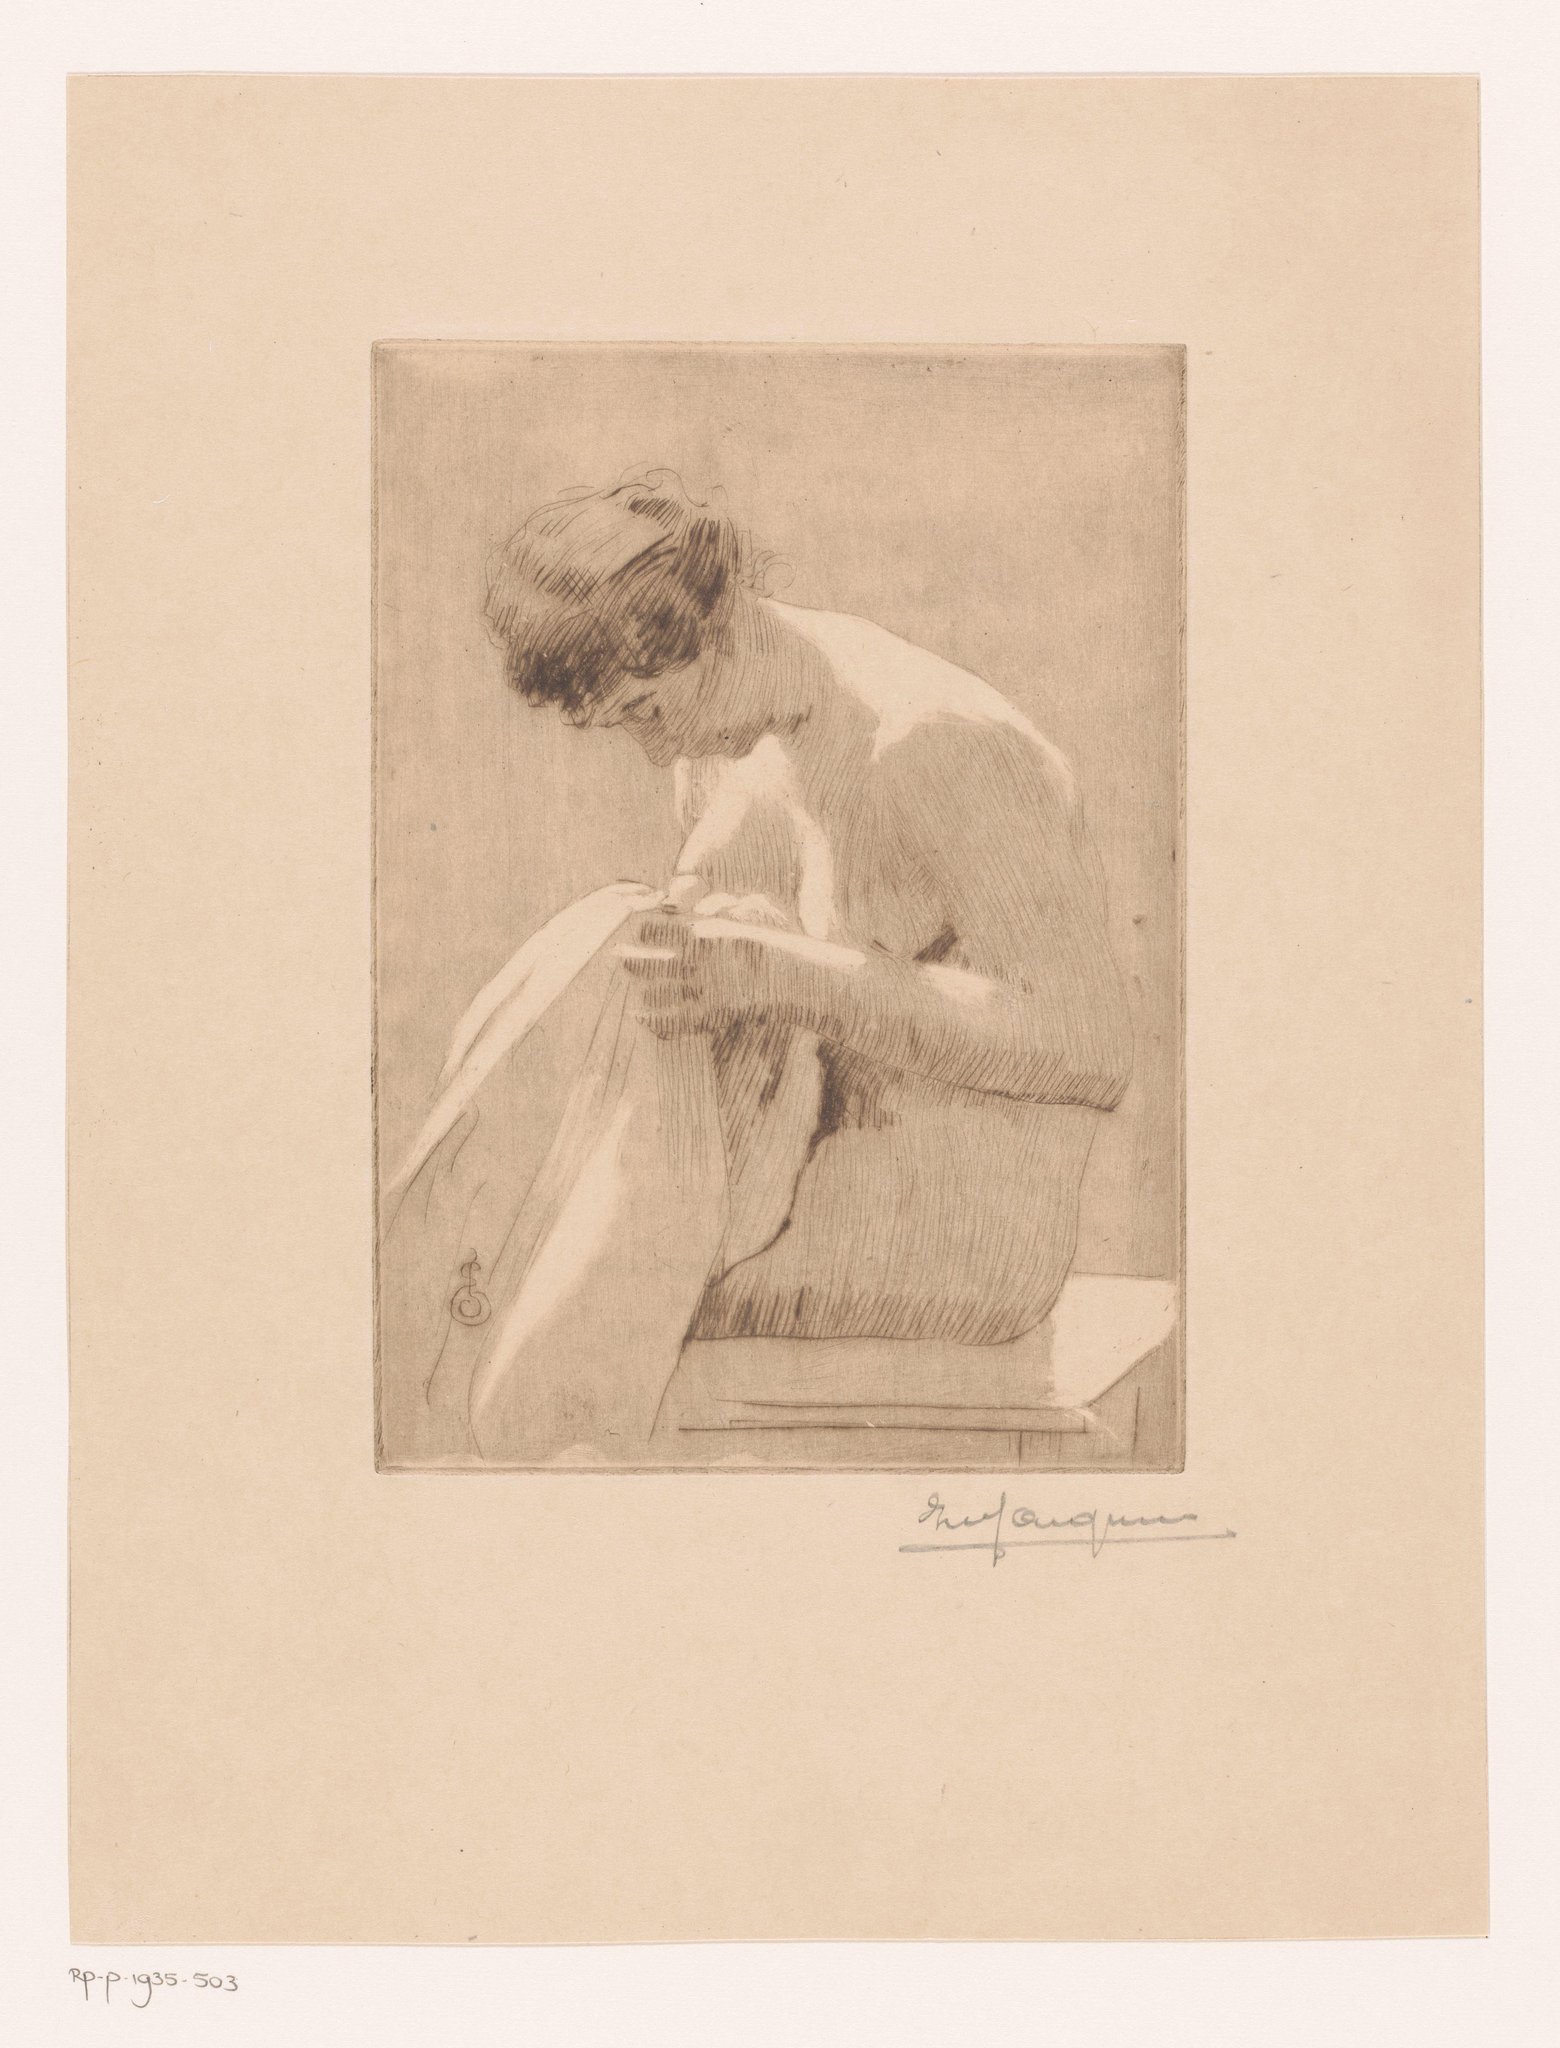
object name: print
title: Baadster of zittend vrouwelijk naakt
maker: emiel jacques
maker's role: print maker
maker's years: 1874-1937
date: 1884-1935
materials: paper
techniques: drypoint, intaglio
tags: (showing oneself) undressed, quasi-nude, the (nude) human figure; 'corpo humano' (ripa) - aa - female human figure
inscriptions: collector's mark: Lugt 2760, collector's mark: Lugt 2228